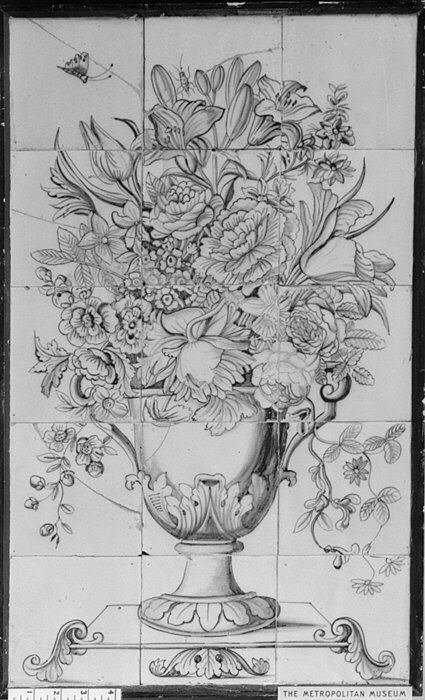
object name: tile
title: Panel of tiles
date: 1725-1775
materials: earthenware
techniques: glazing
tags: butterflies,flowers